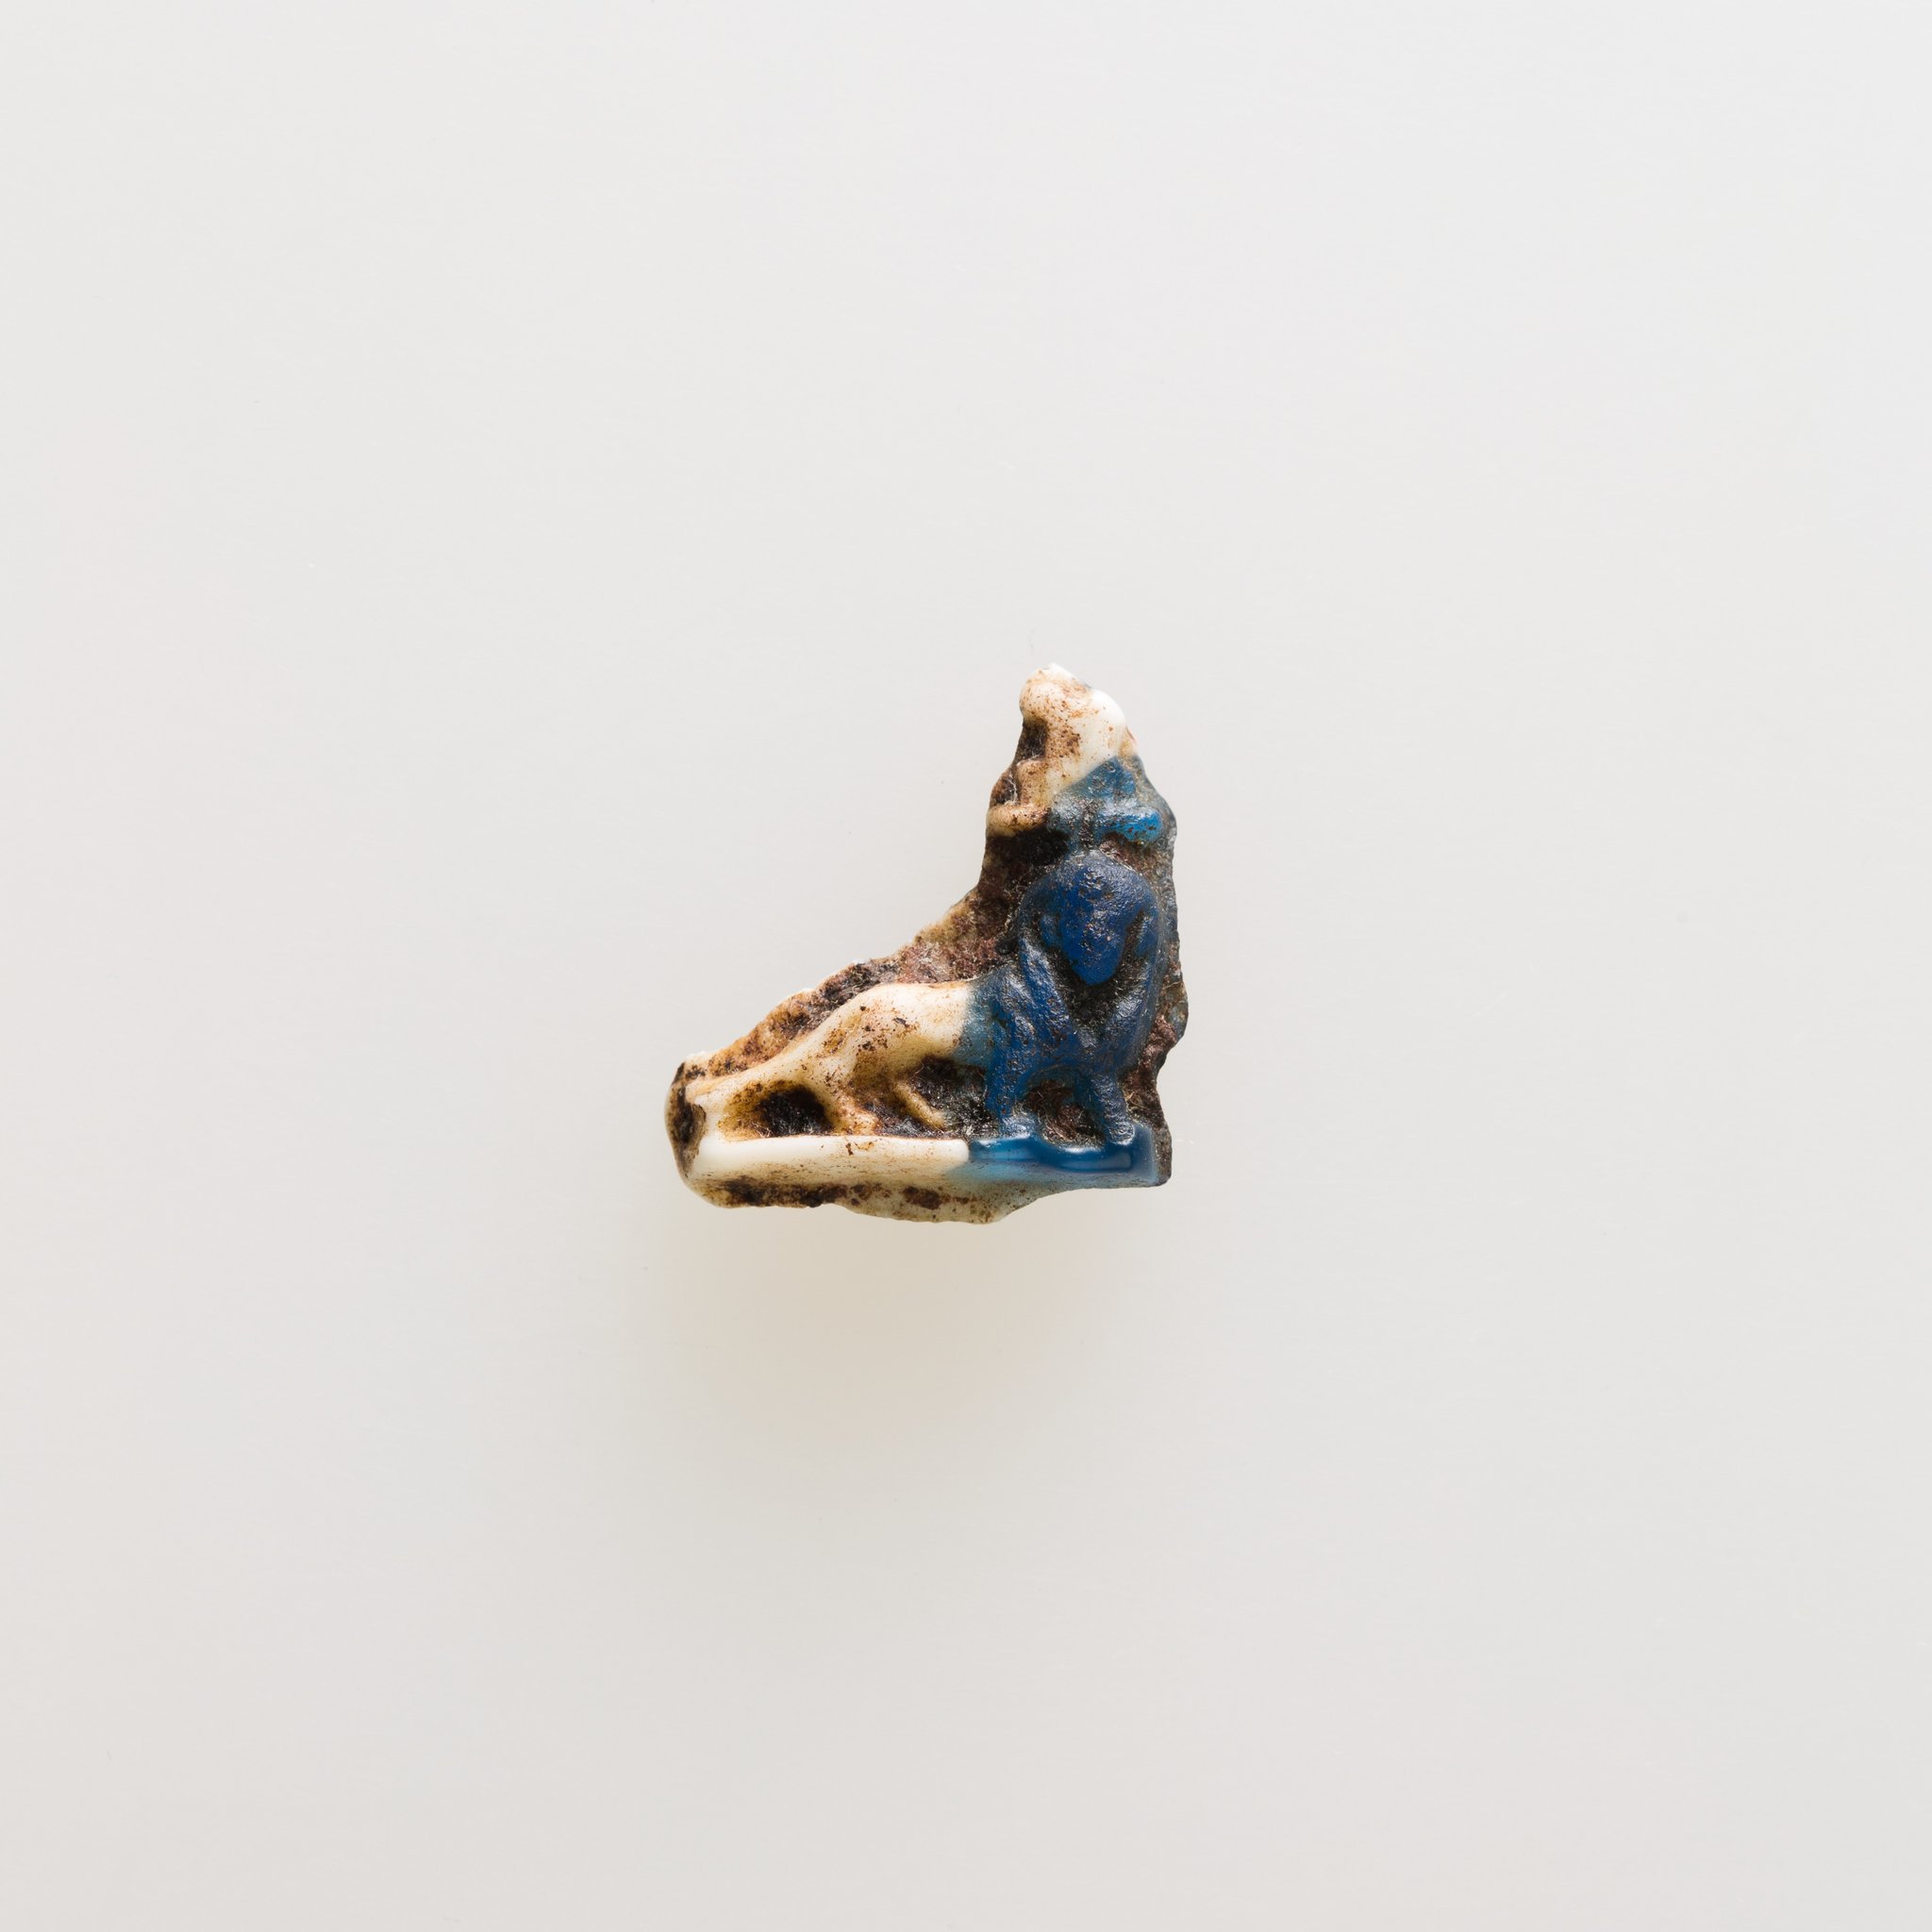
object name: amulet, lion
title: Amulet of Tutu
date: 400-30 BCE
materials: glass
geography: egypt